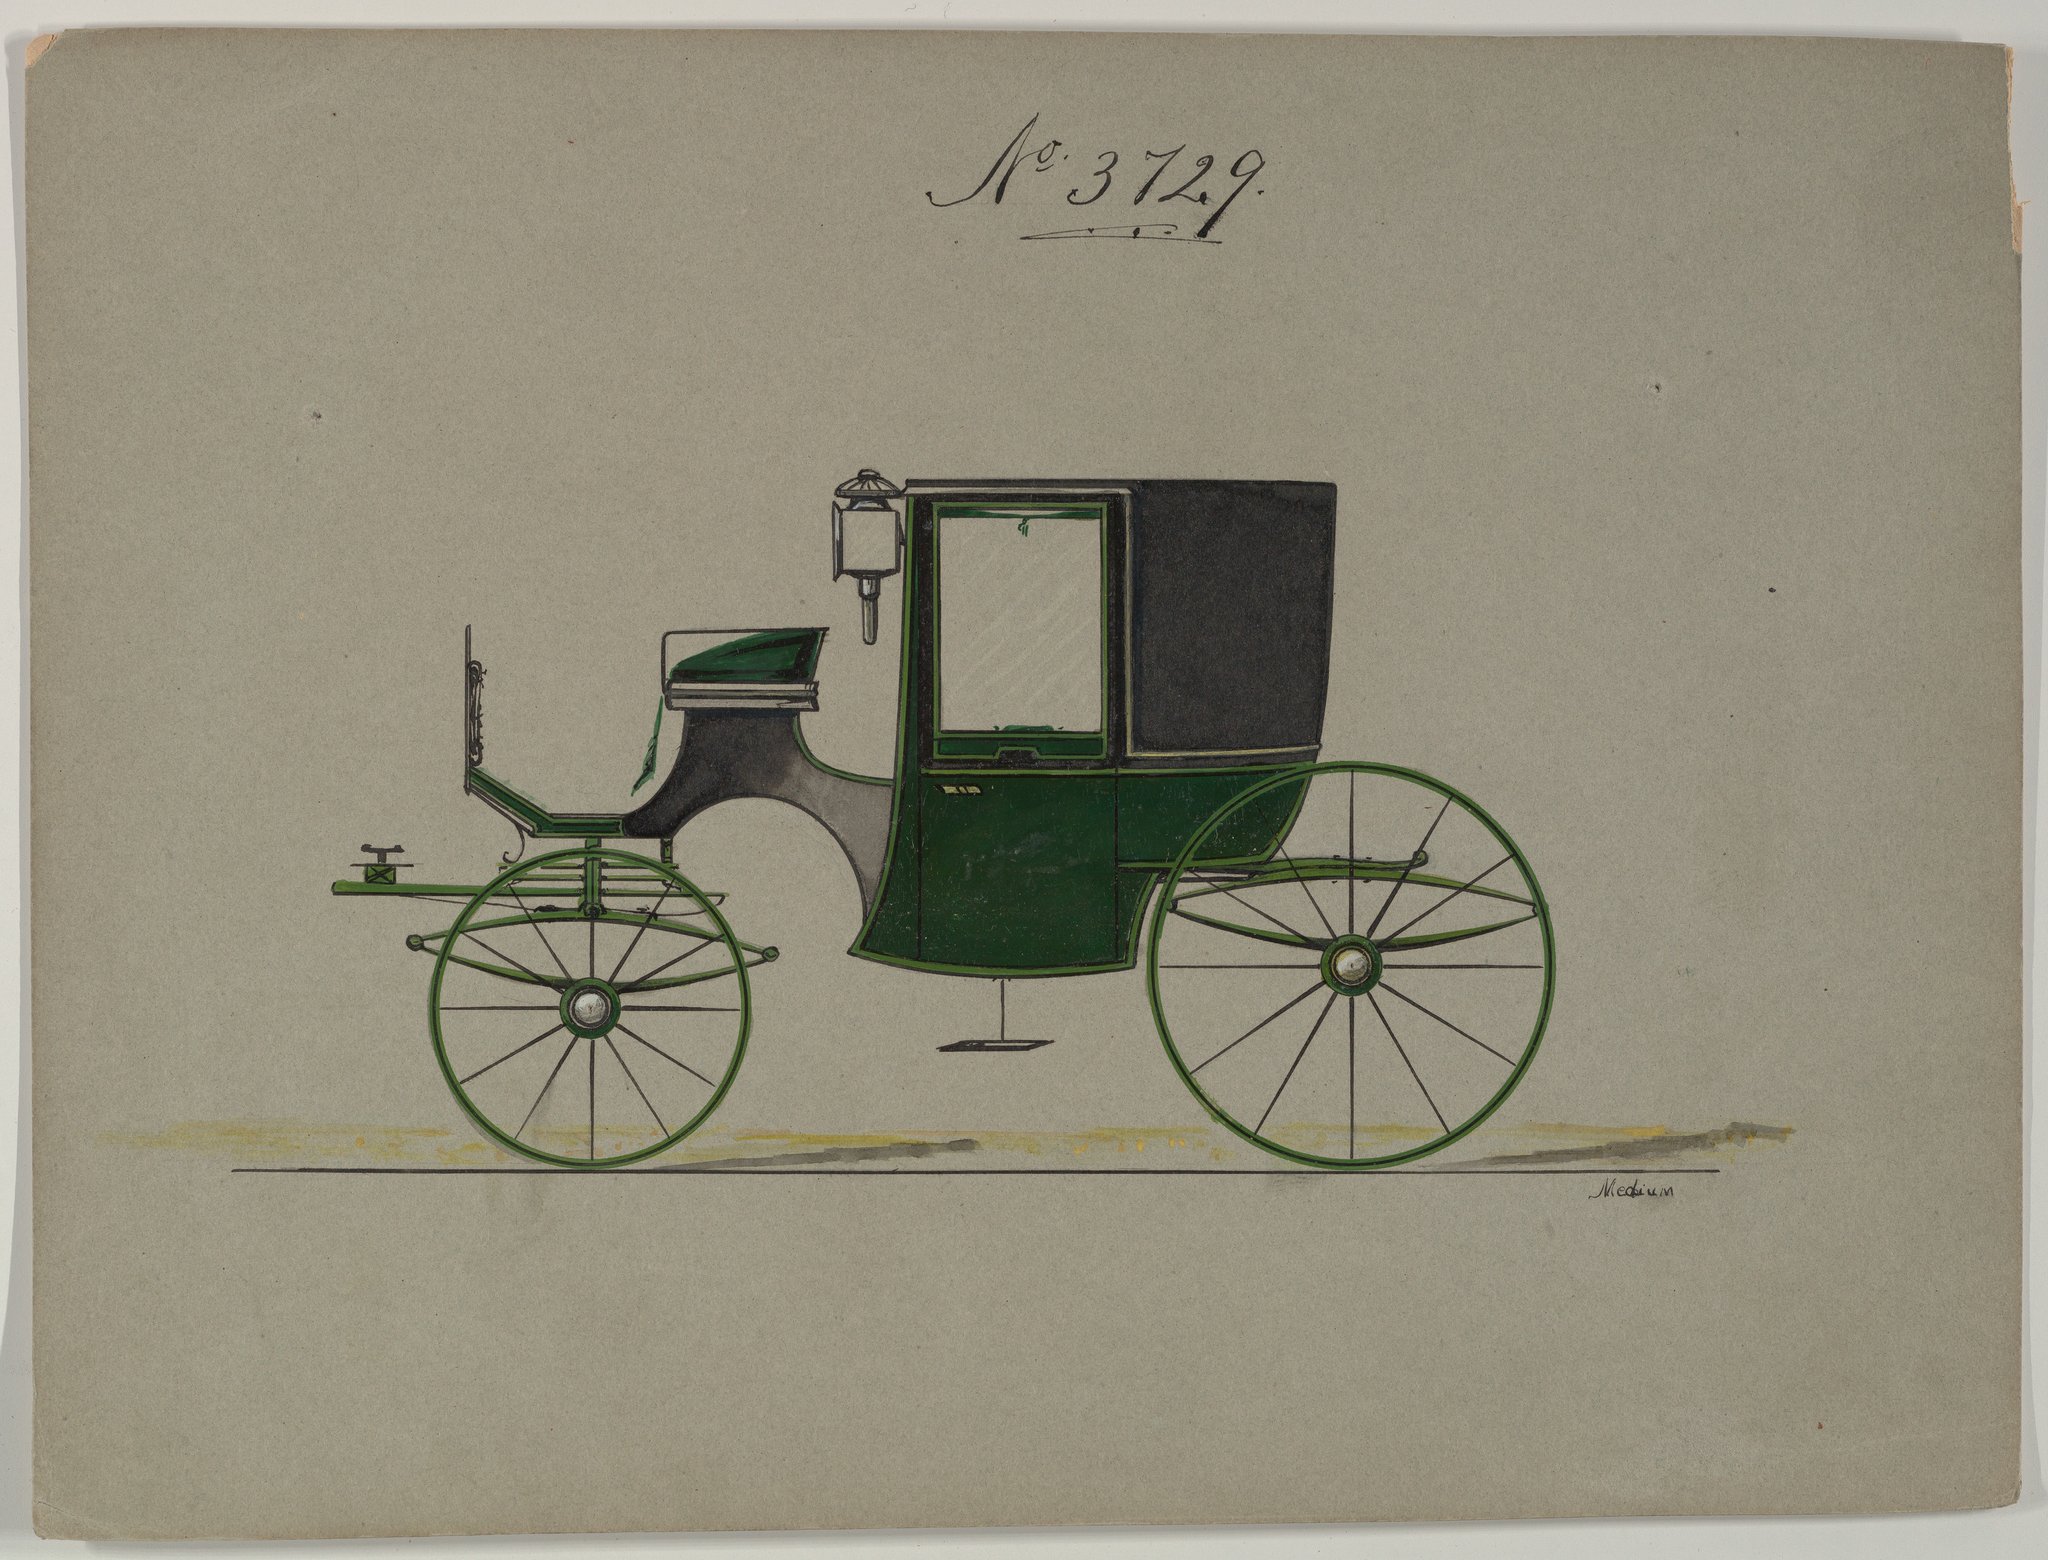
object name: drawing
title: Brougham #3729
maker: brewster & co.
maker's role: manufacturer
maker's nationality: american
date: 1881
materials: gouache, gum arabic, ink, watercolor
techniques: pen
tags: carriages